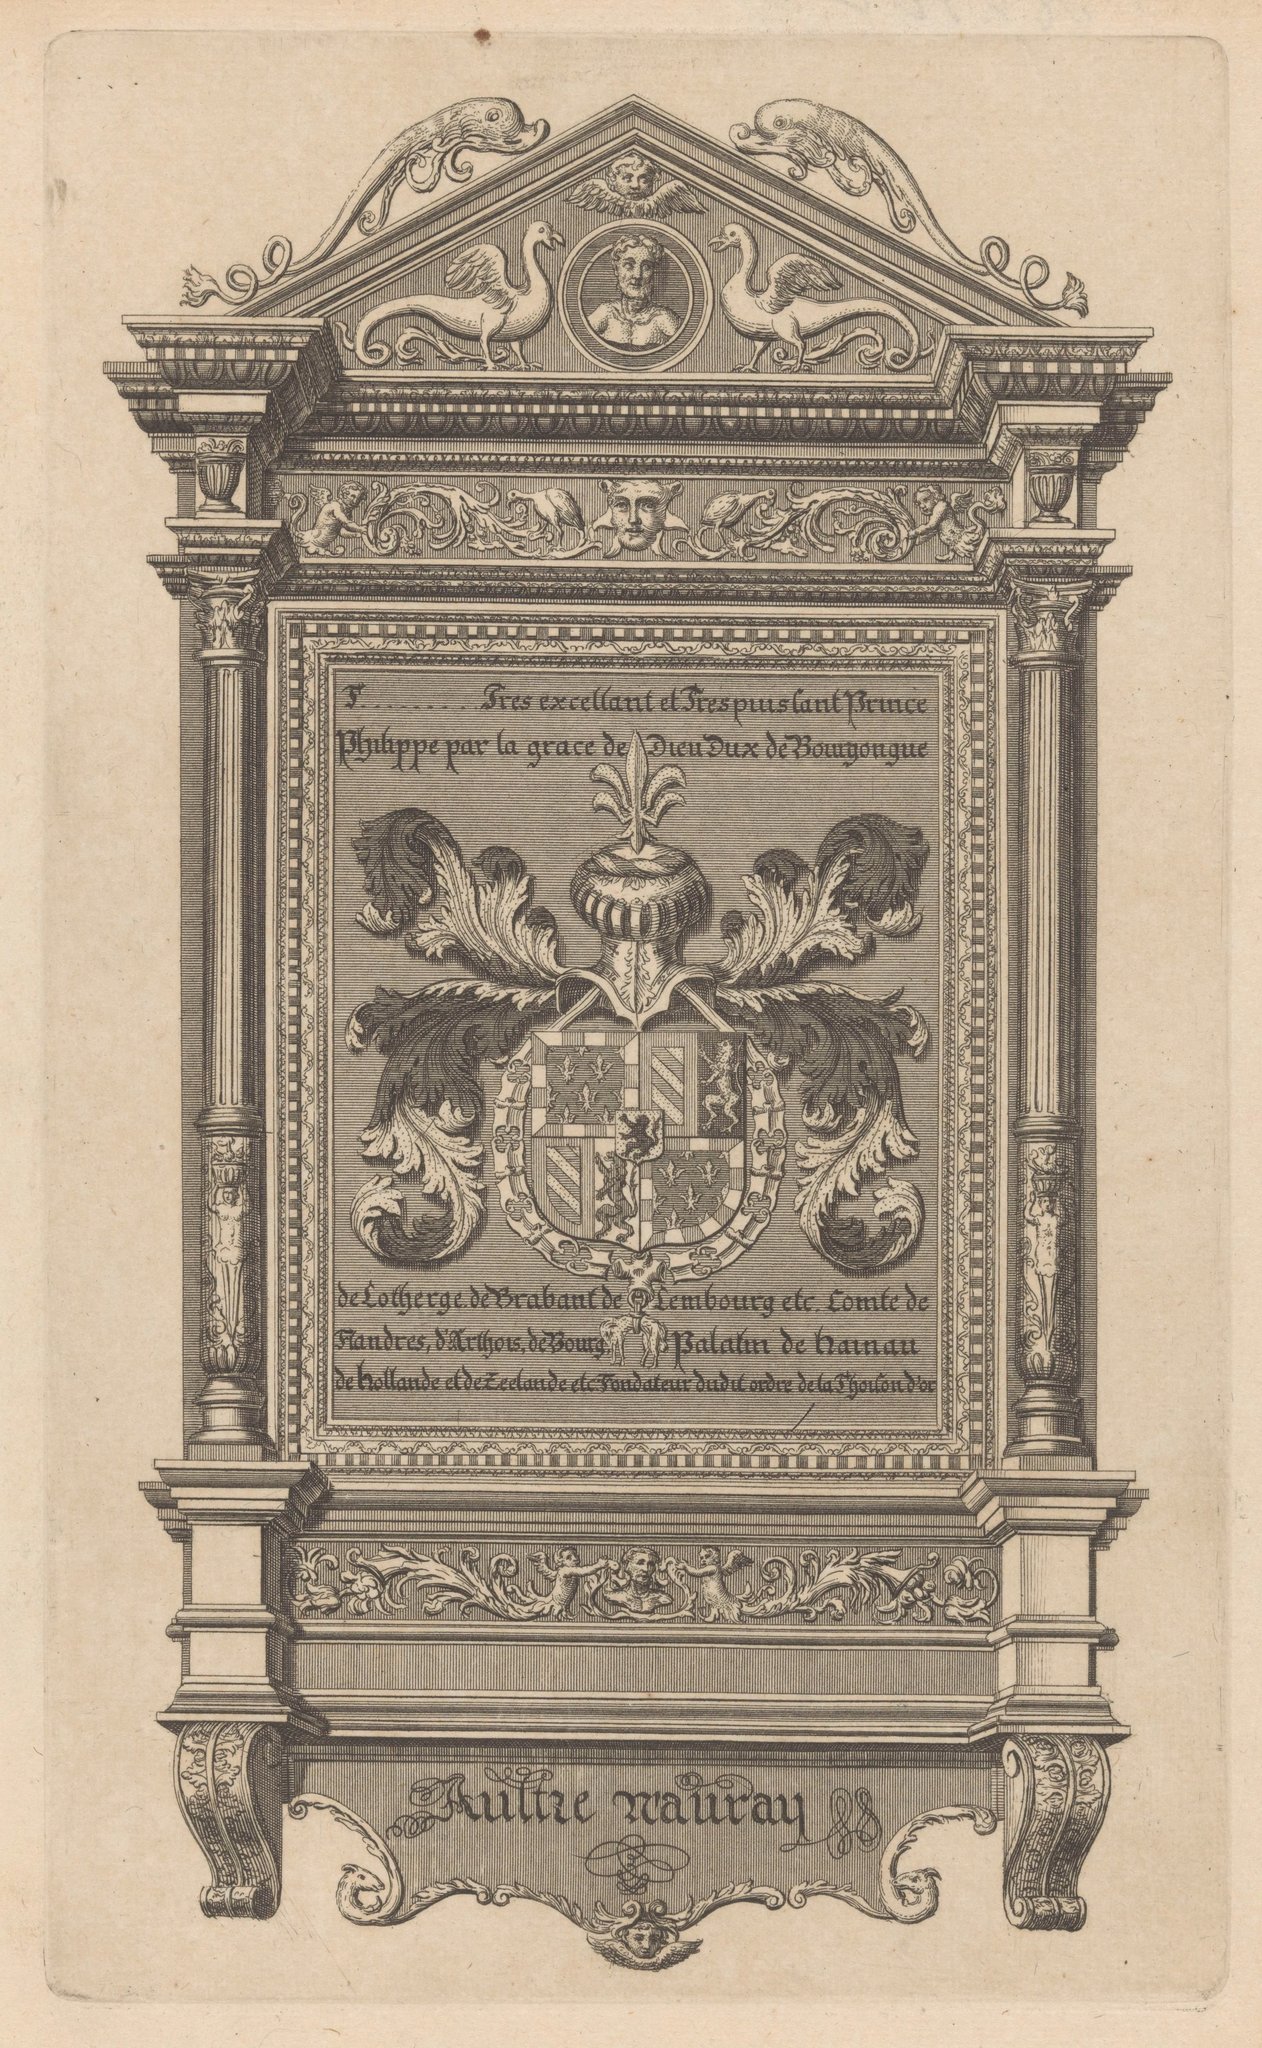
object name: book illustration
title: Wapenbord van Filips de Goede, hertog van Bourgondië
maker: Anonymous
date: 1730-1736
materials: paper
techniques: engraving, etching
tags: bruges, philip iii the good, armorial bearing, heraldry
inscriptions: collector's mark: Lugt 2228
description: Wapenbord van Filips de Goede, hertog van Bourgondië, in de Grote- of Sint-Jacobskerk te Den Haag.